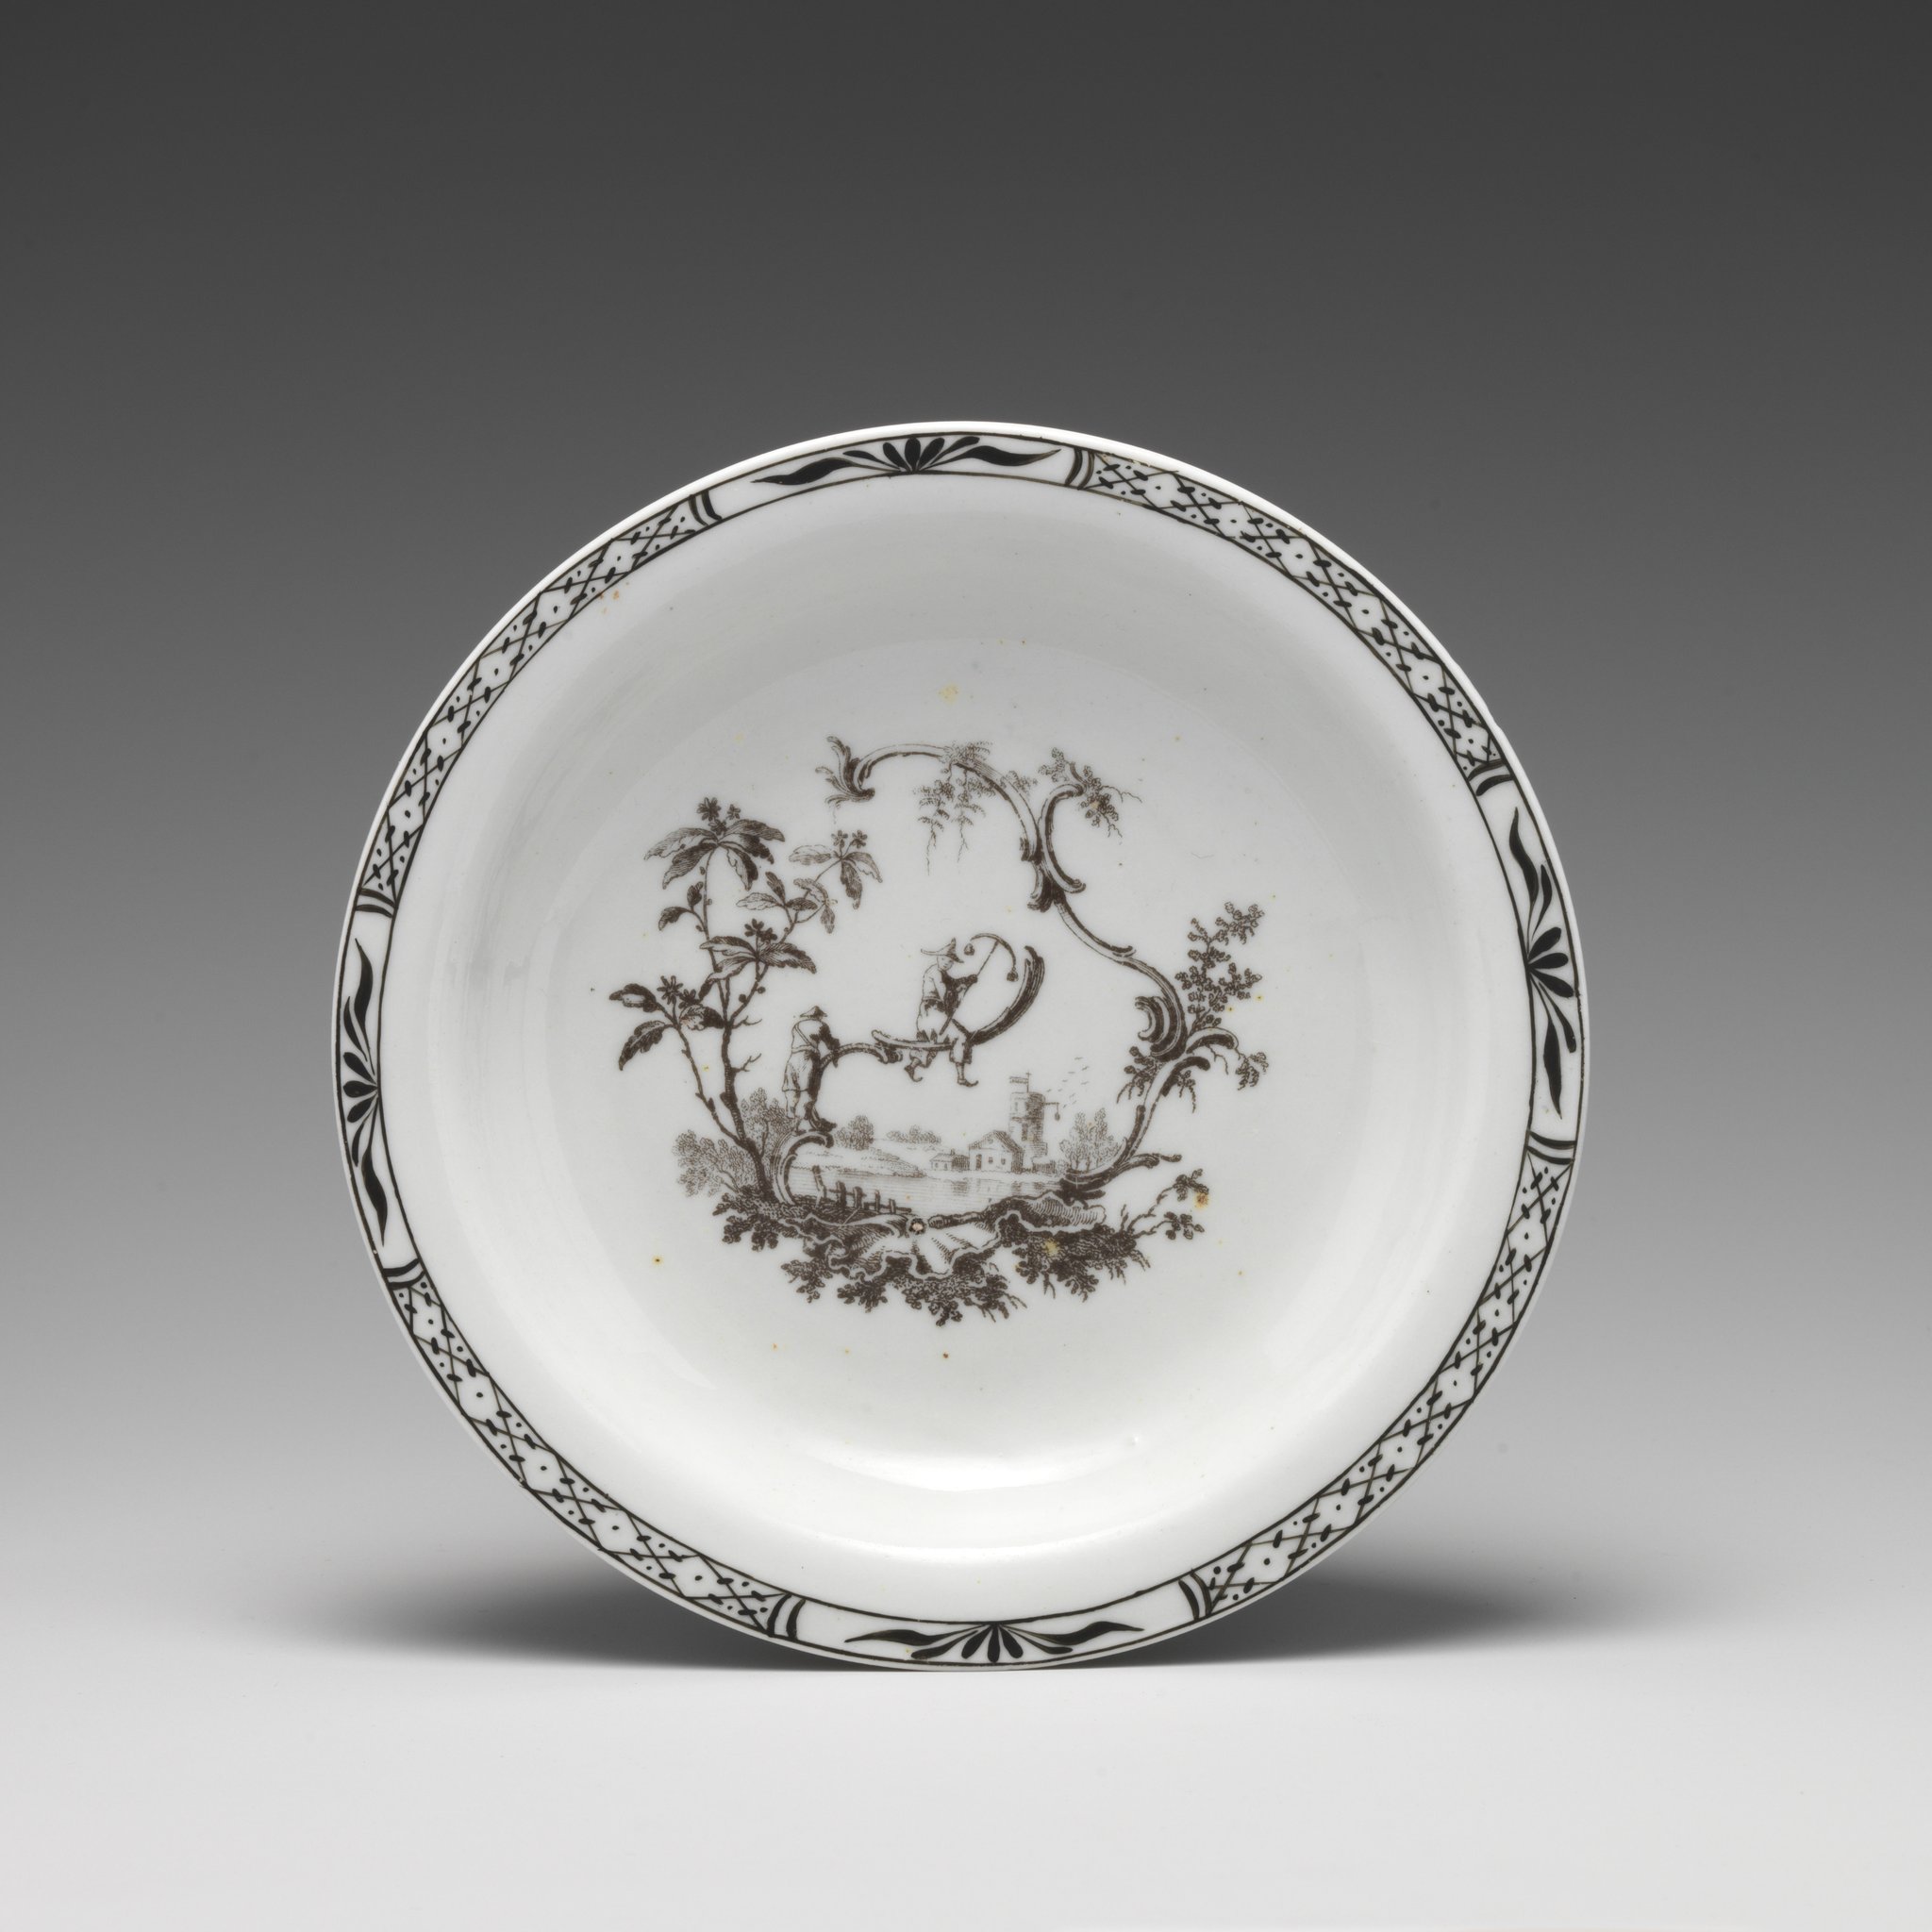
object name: plate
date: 1701-1800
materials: soft paste porcelain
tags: human figures,trees